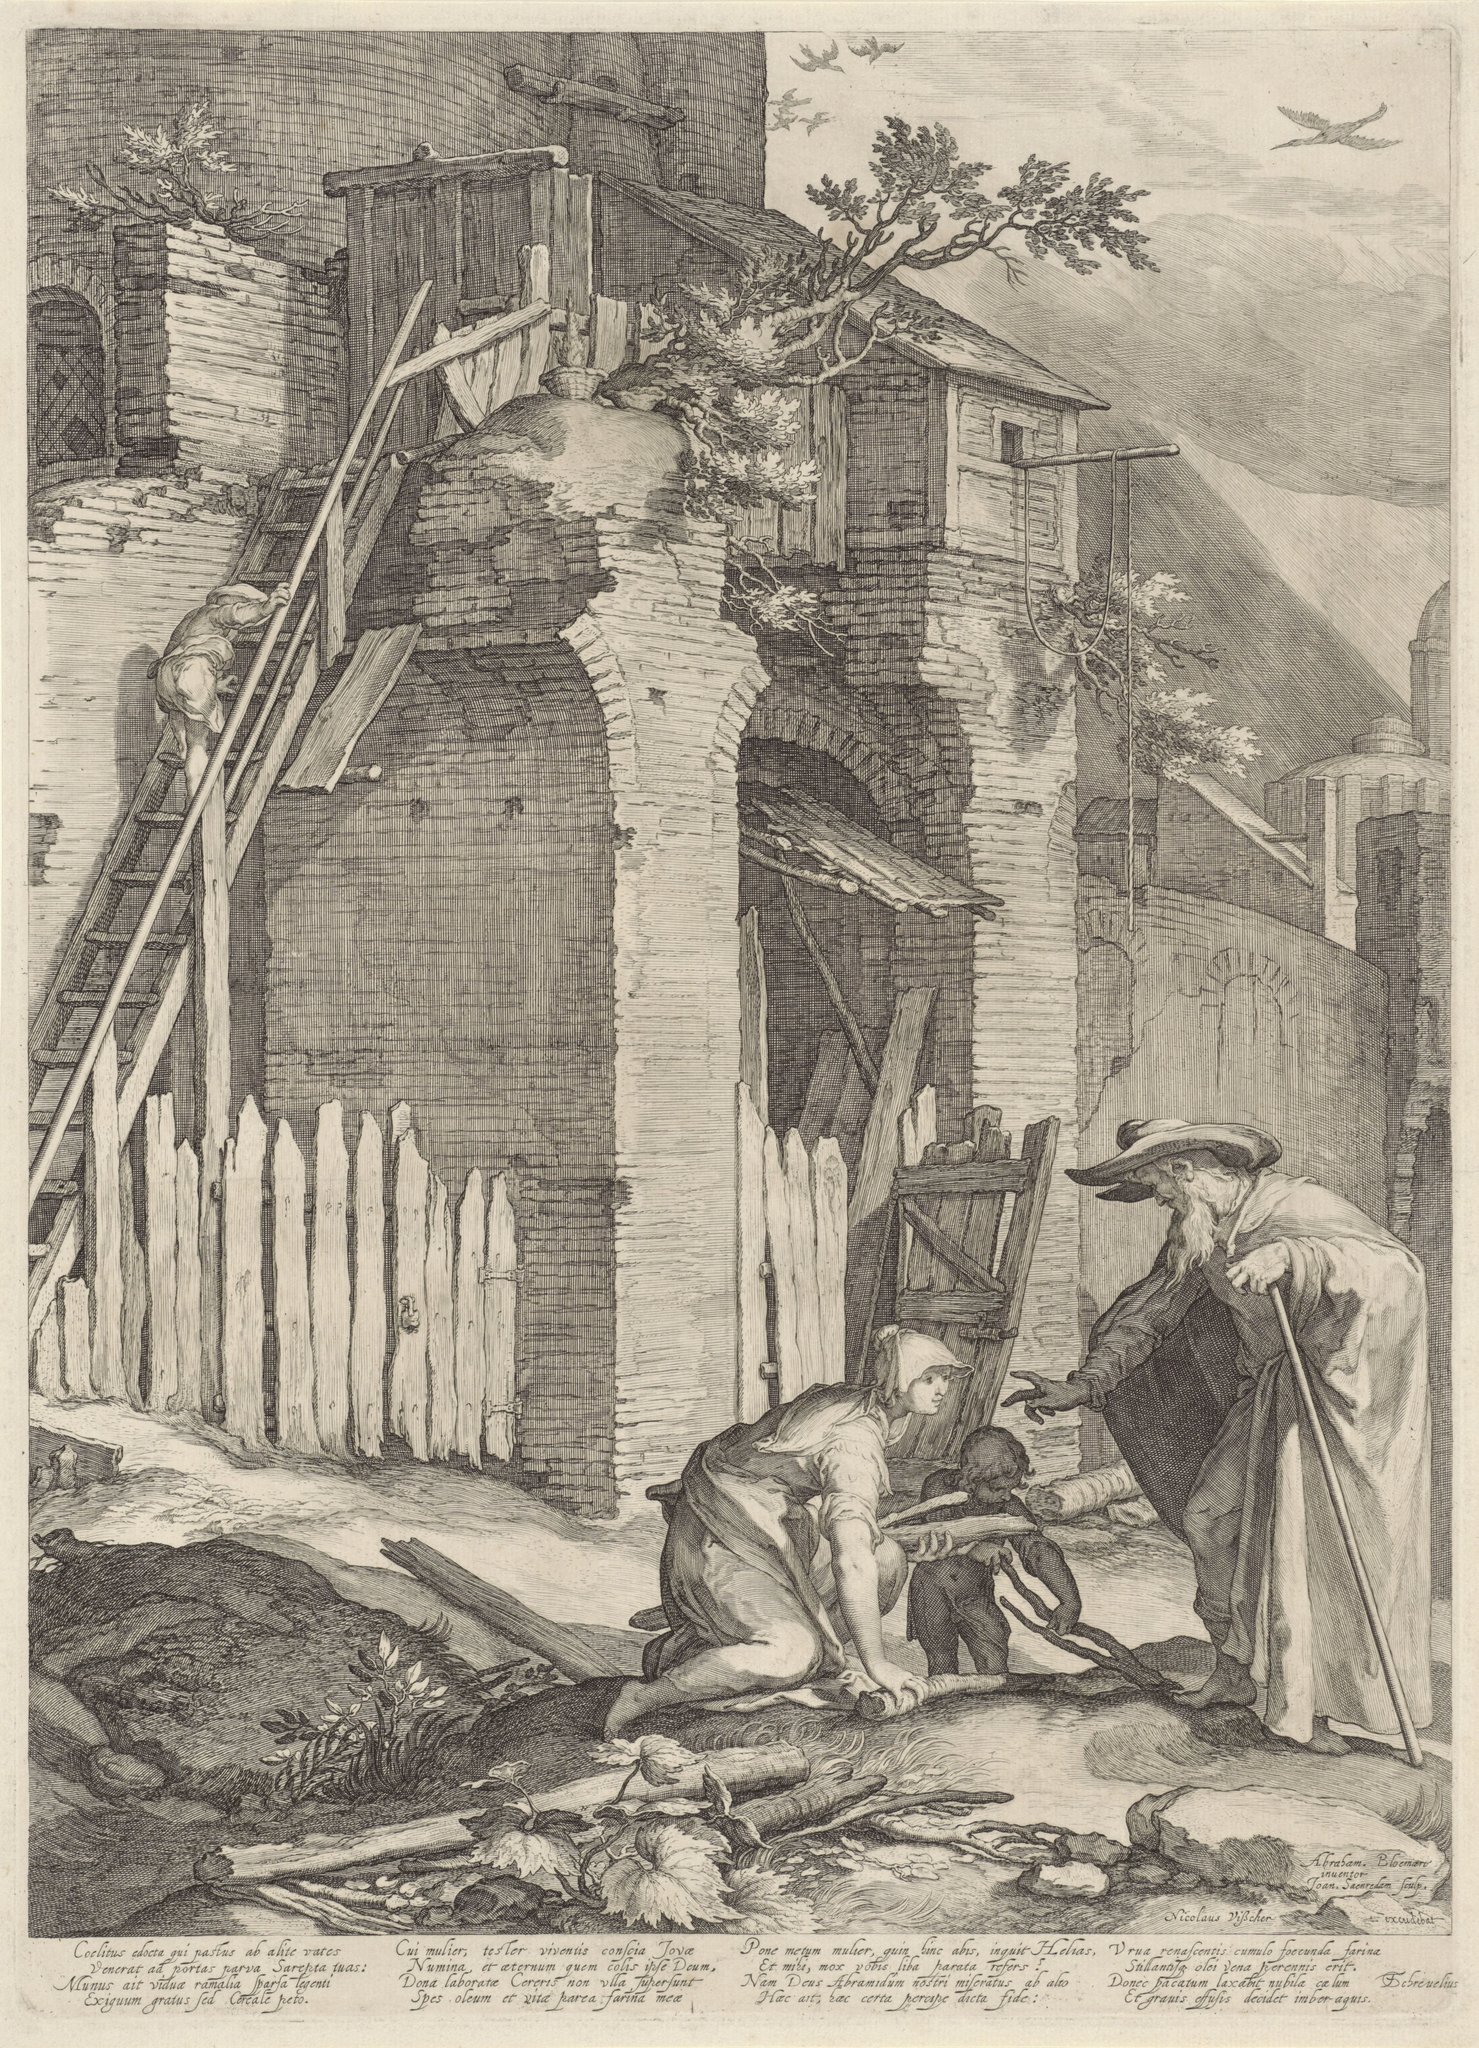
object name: print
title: Elia ontmoet de weduwe van Sarefat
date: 1604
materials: paper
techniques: engraving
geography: assendelft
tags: when the brook dries up, elijah crosses over to the city of zarephath; at the gate he meets a woman and her little son gathering wood (the woman's sticks may form a cross)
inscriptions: collector's mark: Lugt 2228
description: Op weg naar Sarefat ontmoet Elia een weduwe en haar zoon die op zoek zijn naar sprokkelhout. Elia stuurt haar naar huis om eten voor hem te maken. De prent heeft een Latijnse tekst in de ondermarge.